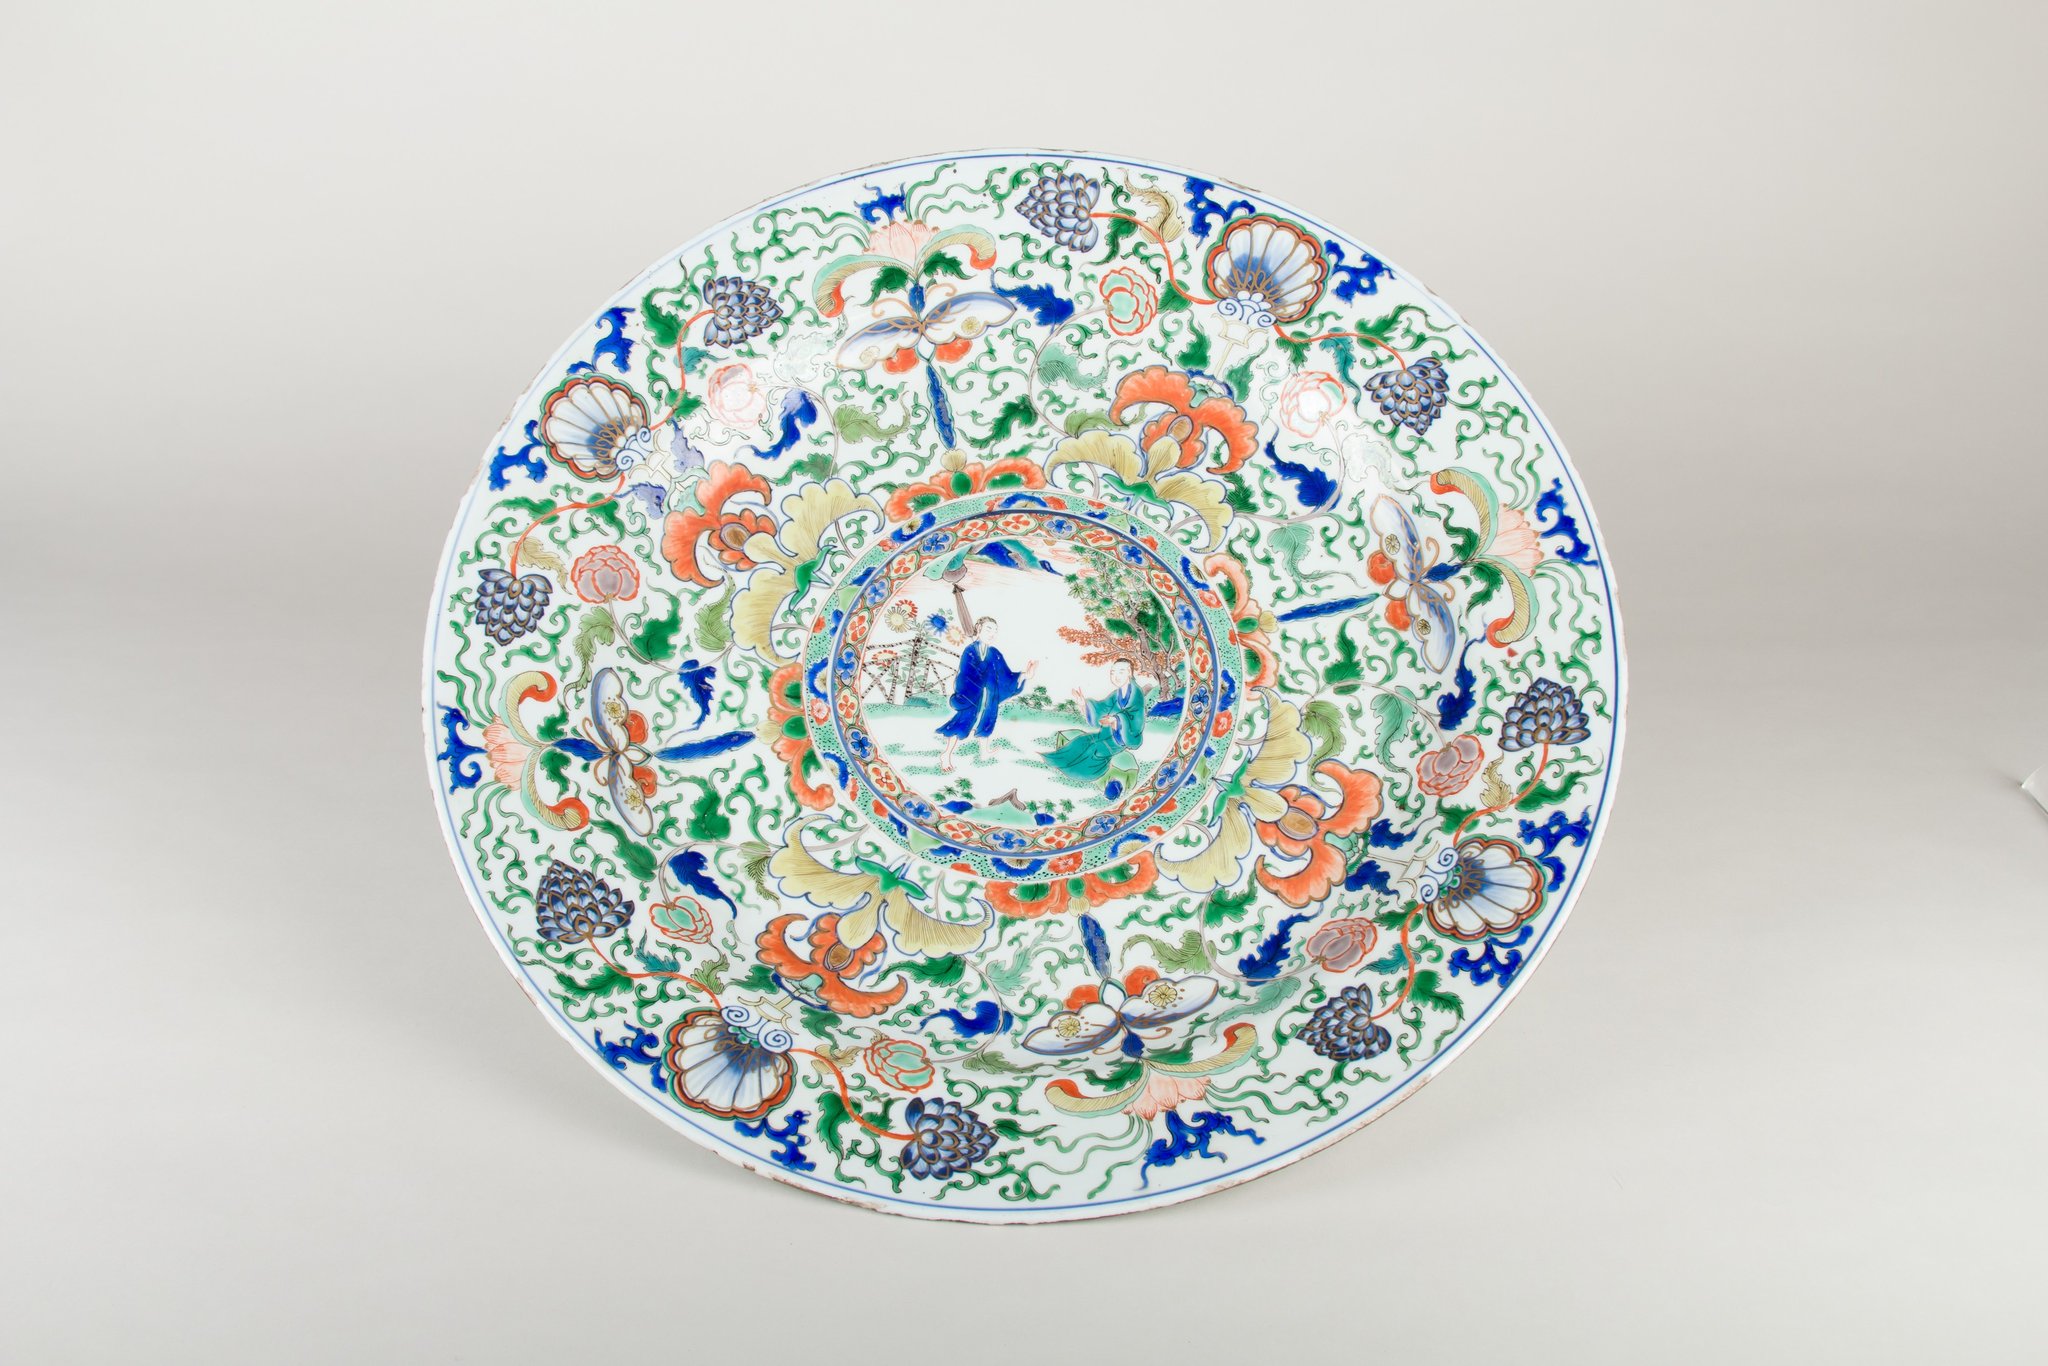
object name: plate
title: Plate with human figures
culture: chinese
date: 1667-1733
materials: cobalt, enamel, porcelain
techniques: overglaze, painting, polychrome, underglaze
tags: men